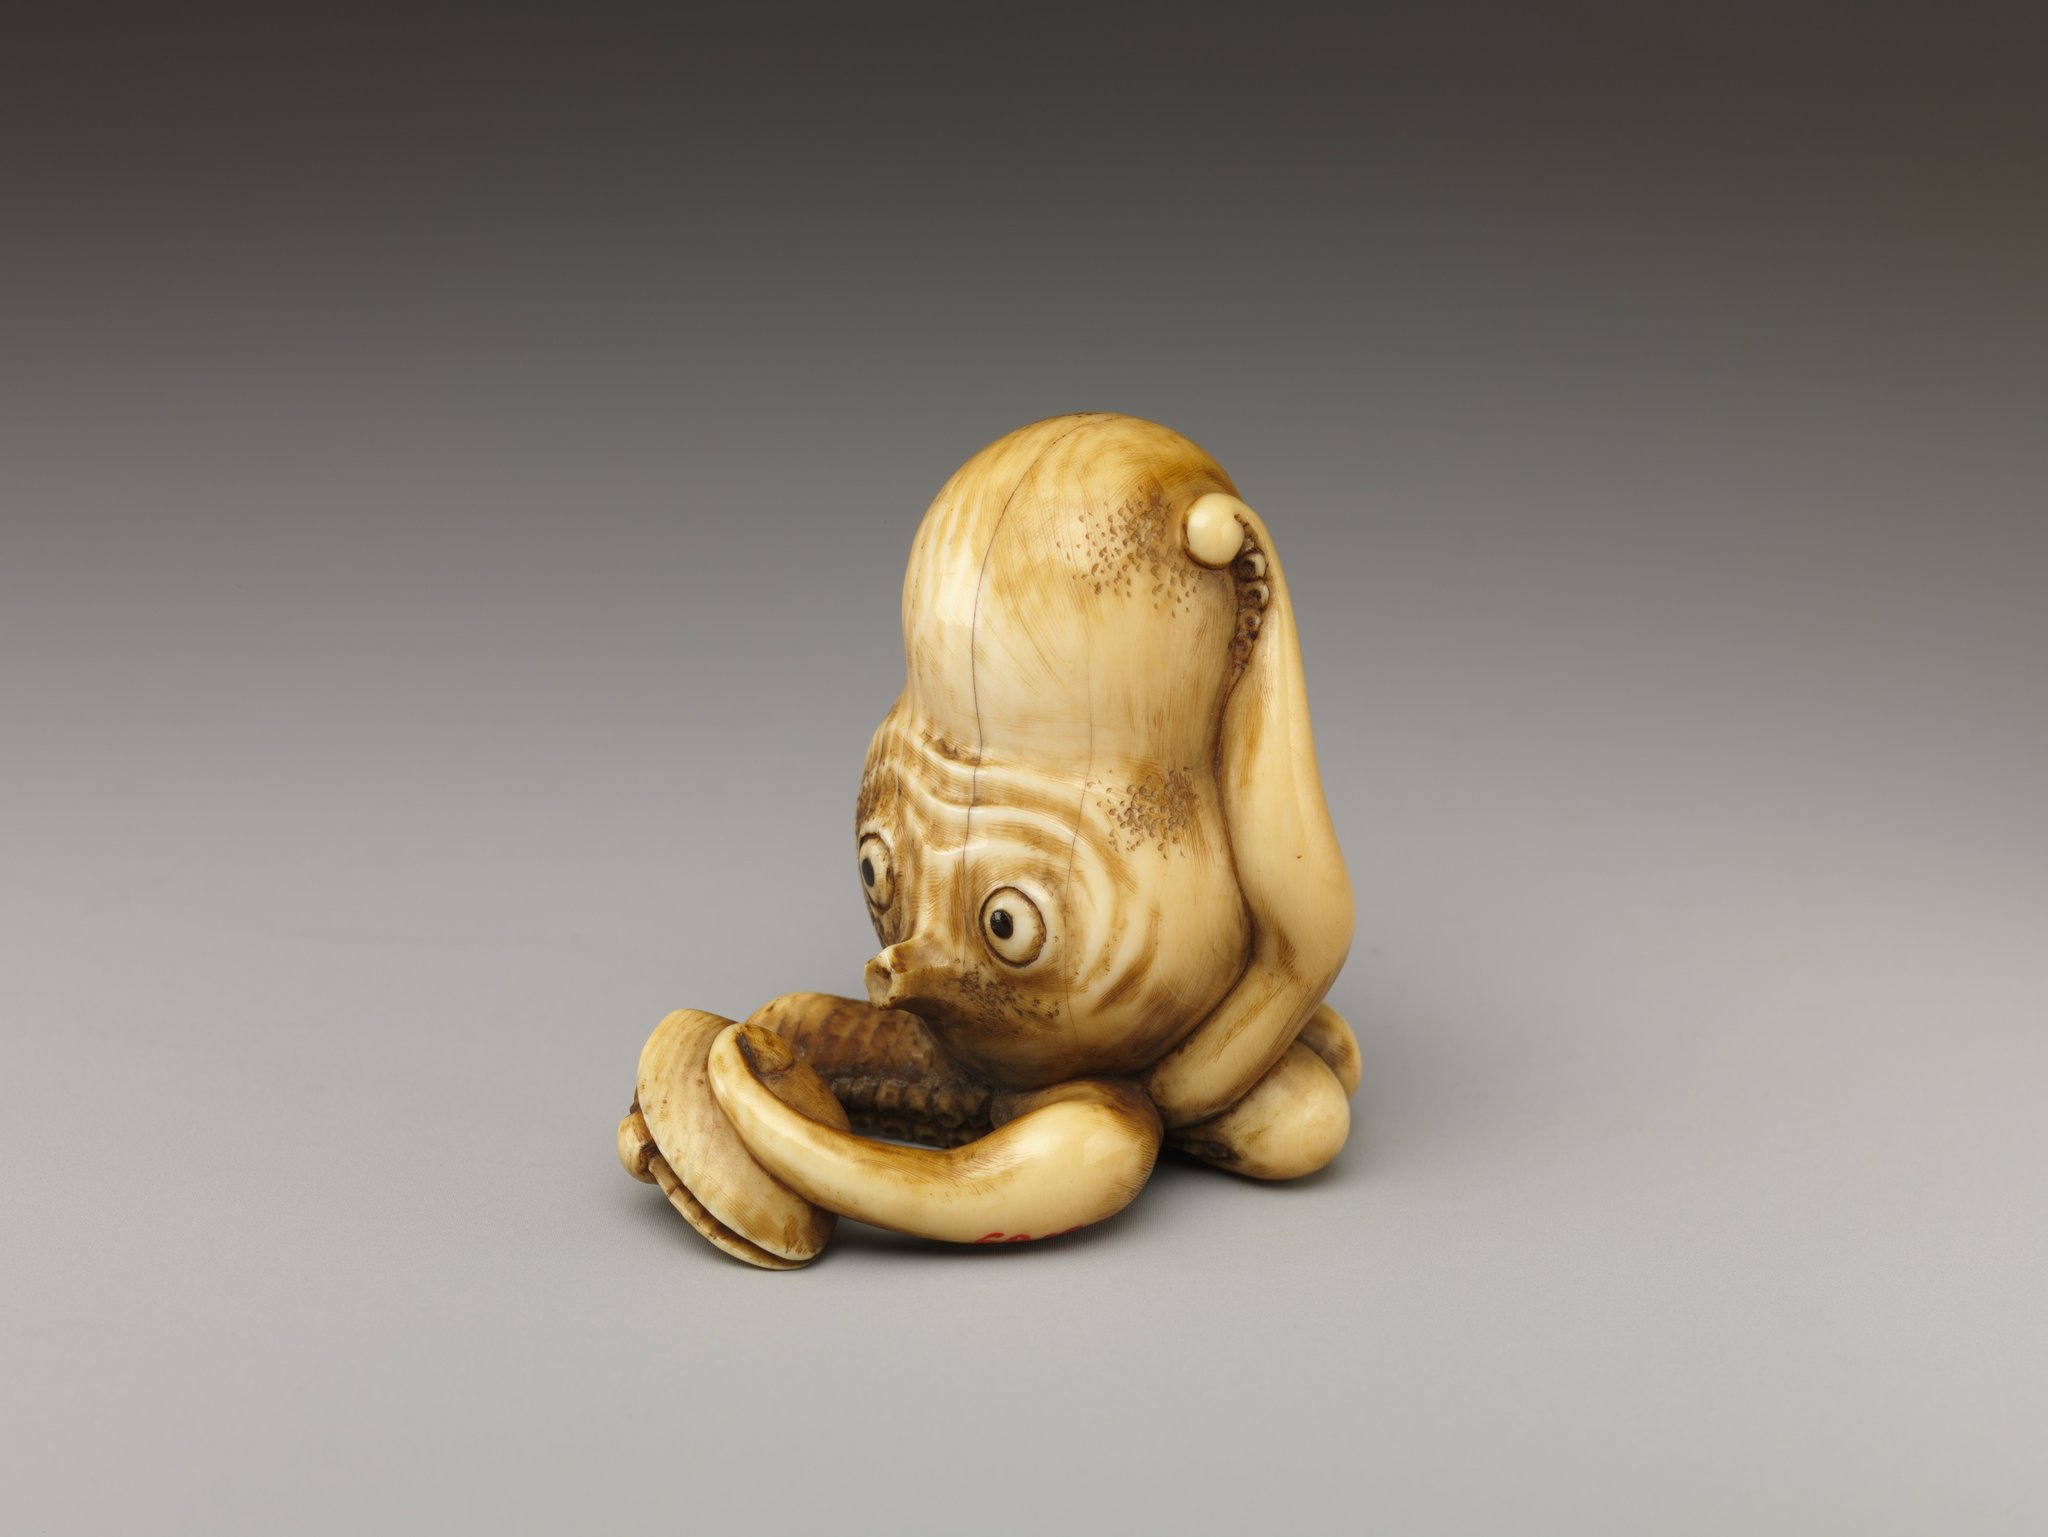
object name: netsuke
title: Netsuke of Octopus Holding Clam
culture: japanese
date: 1867-1933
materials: ivory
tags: octopus